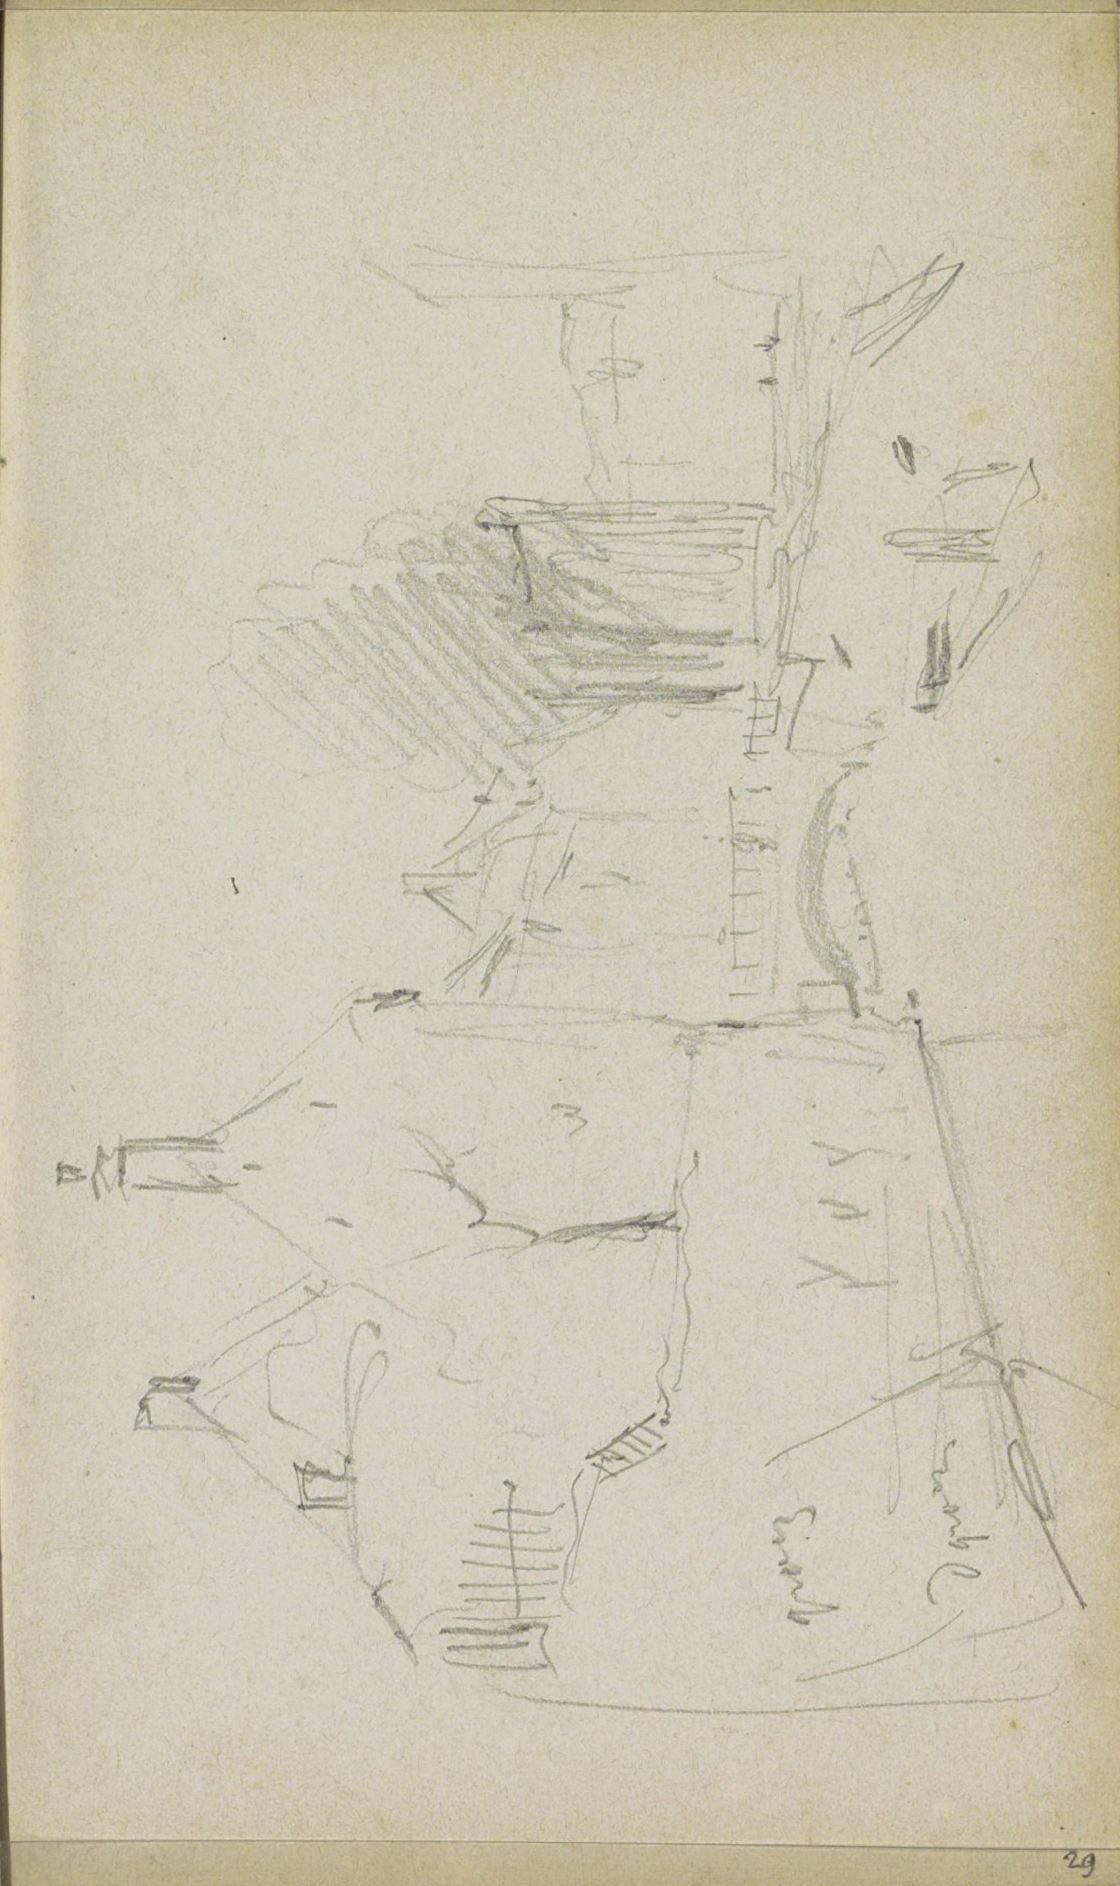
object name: sketchbook leaf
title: Stadsgezicht met een gracht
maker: adrianus eversen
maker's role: draughtsman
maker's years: 1818-1897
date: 1828-1897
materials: paper, pencil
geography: netherlands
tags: urban housing, bridge in city across river, canal, etc.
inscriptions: kleurnotitie, handgeschreven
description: In het midden een brug over een gracht. Aan weerszijden van de gracht bebouwing. Blad 29 recto uit een schetsboek met 69 bladen vervaardigd in de omgeving van Delft, Rotterdam, Oudewater en Harlingen.